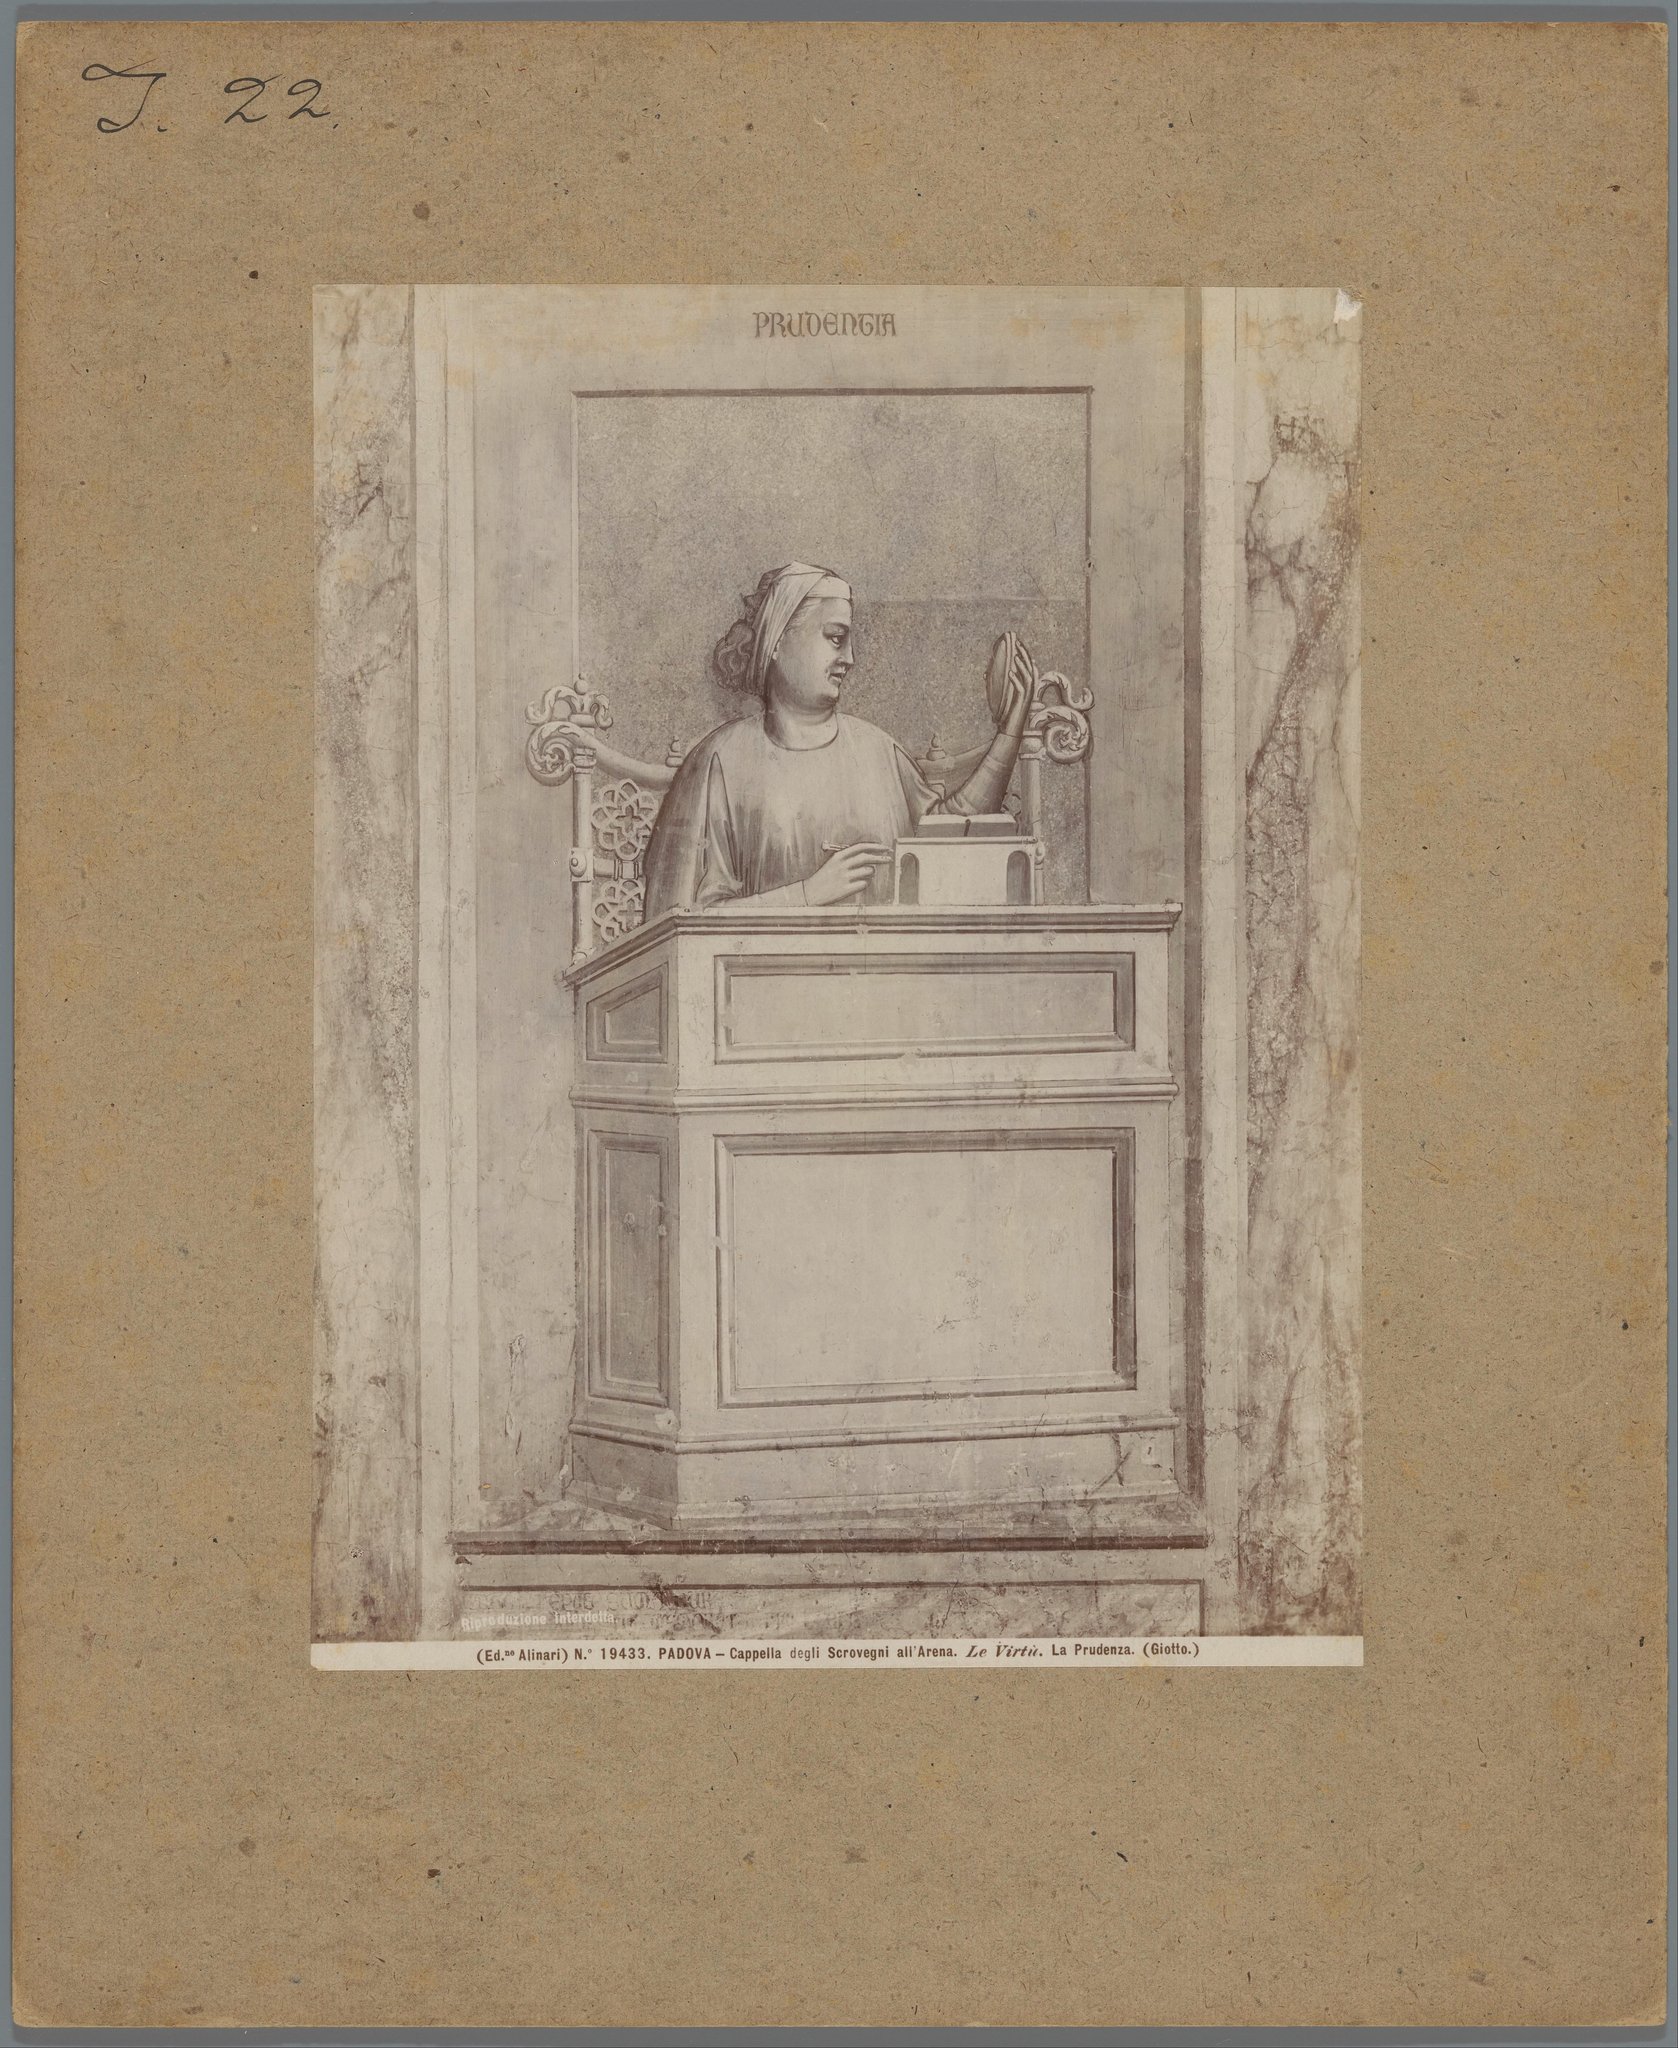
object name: reproduction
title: Fotoreproductie van een schildering door Giotto, voorstellende de Voorzichtigheid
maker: giotto de bondone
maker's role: painter, sculptor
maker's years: 1266-1337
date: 1875-1900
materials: cardboard, photographic support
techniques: albumen print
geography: scrovegnikapel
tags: prudence, 'prudentia'; 'prudenza' (ripa) ~ one of the four cardinal virtues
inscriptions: collector's mark: Lugt 3937, number: ‘No. 19433.’